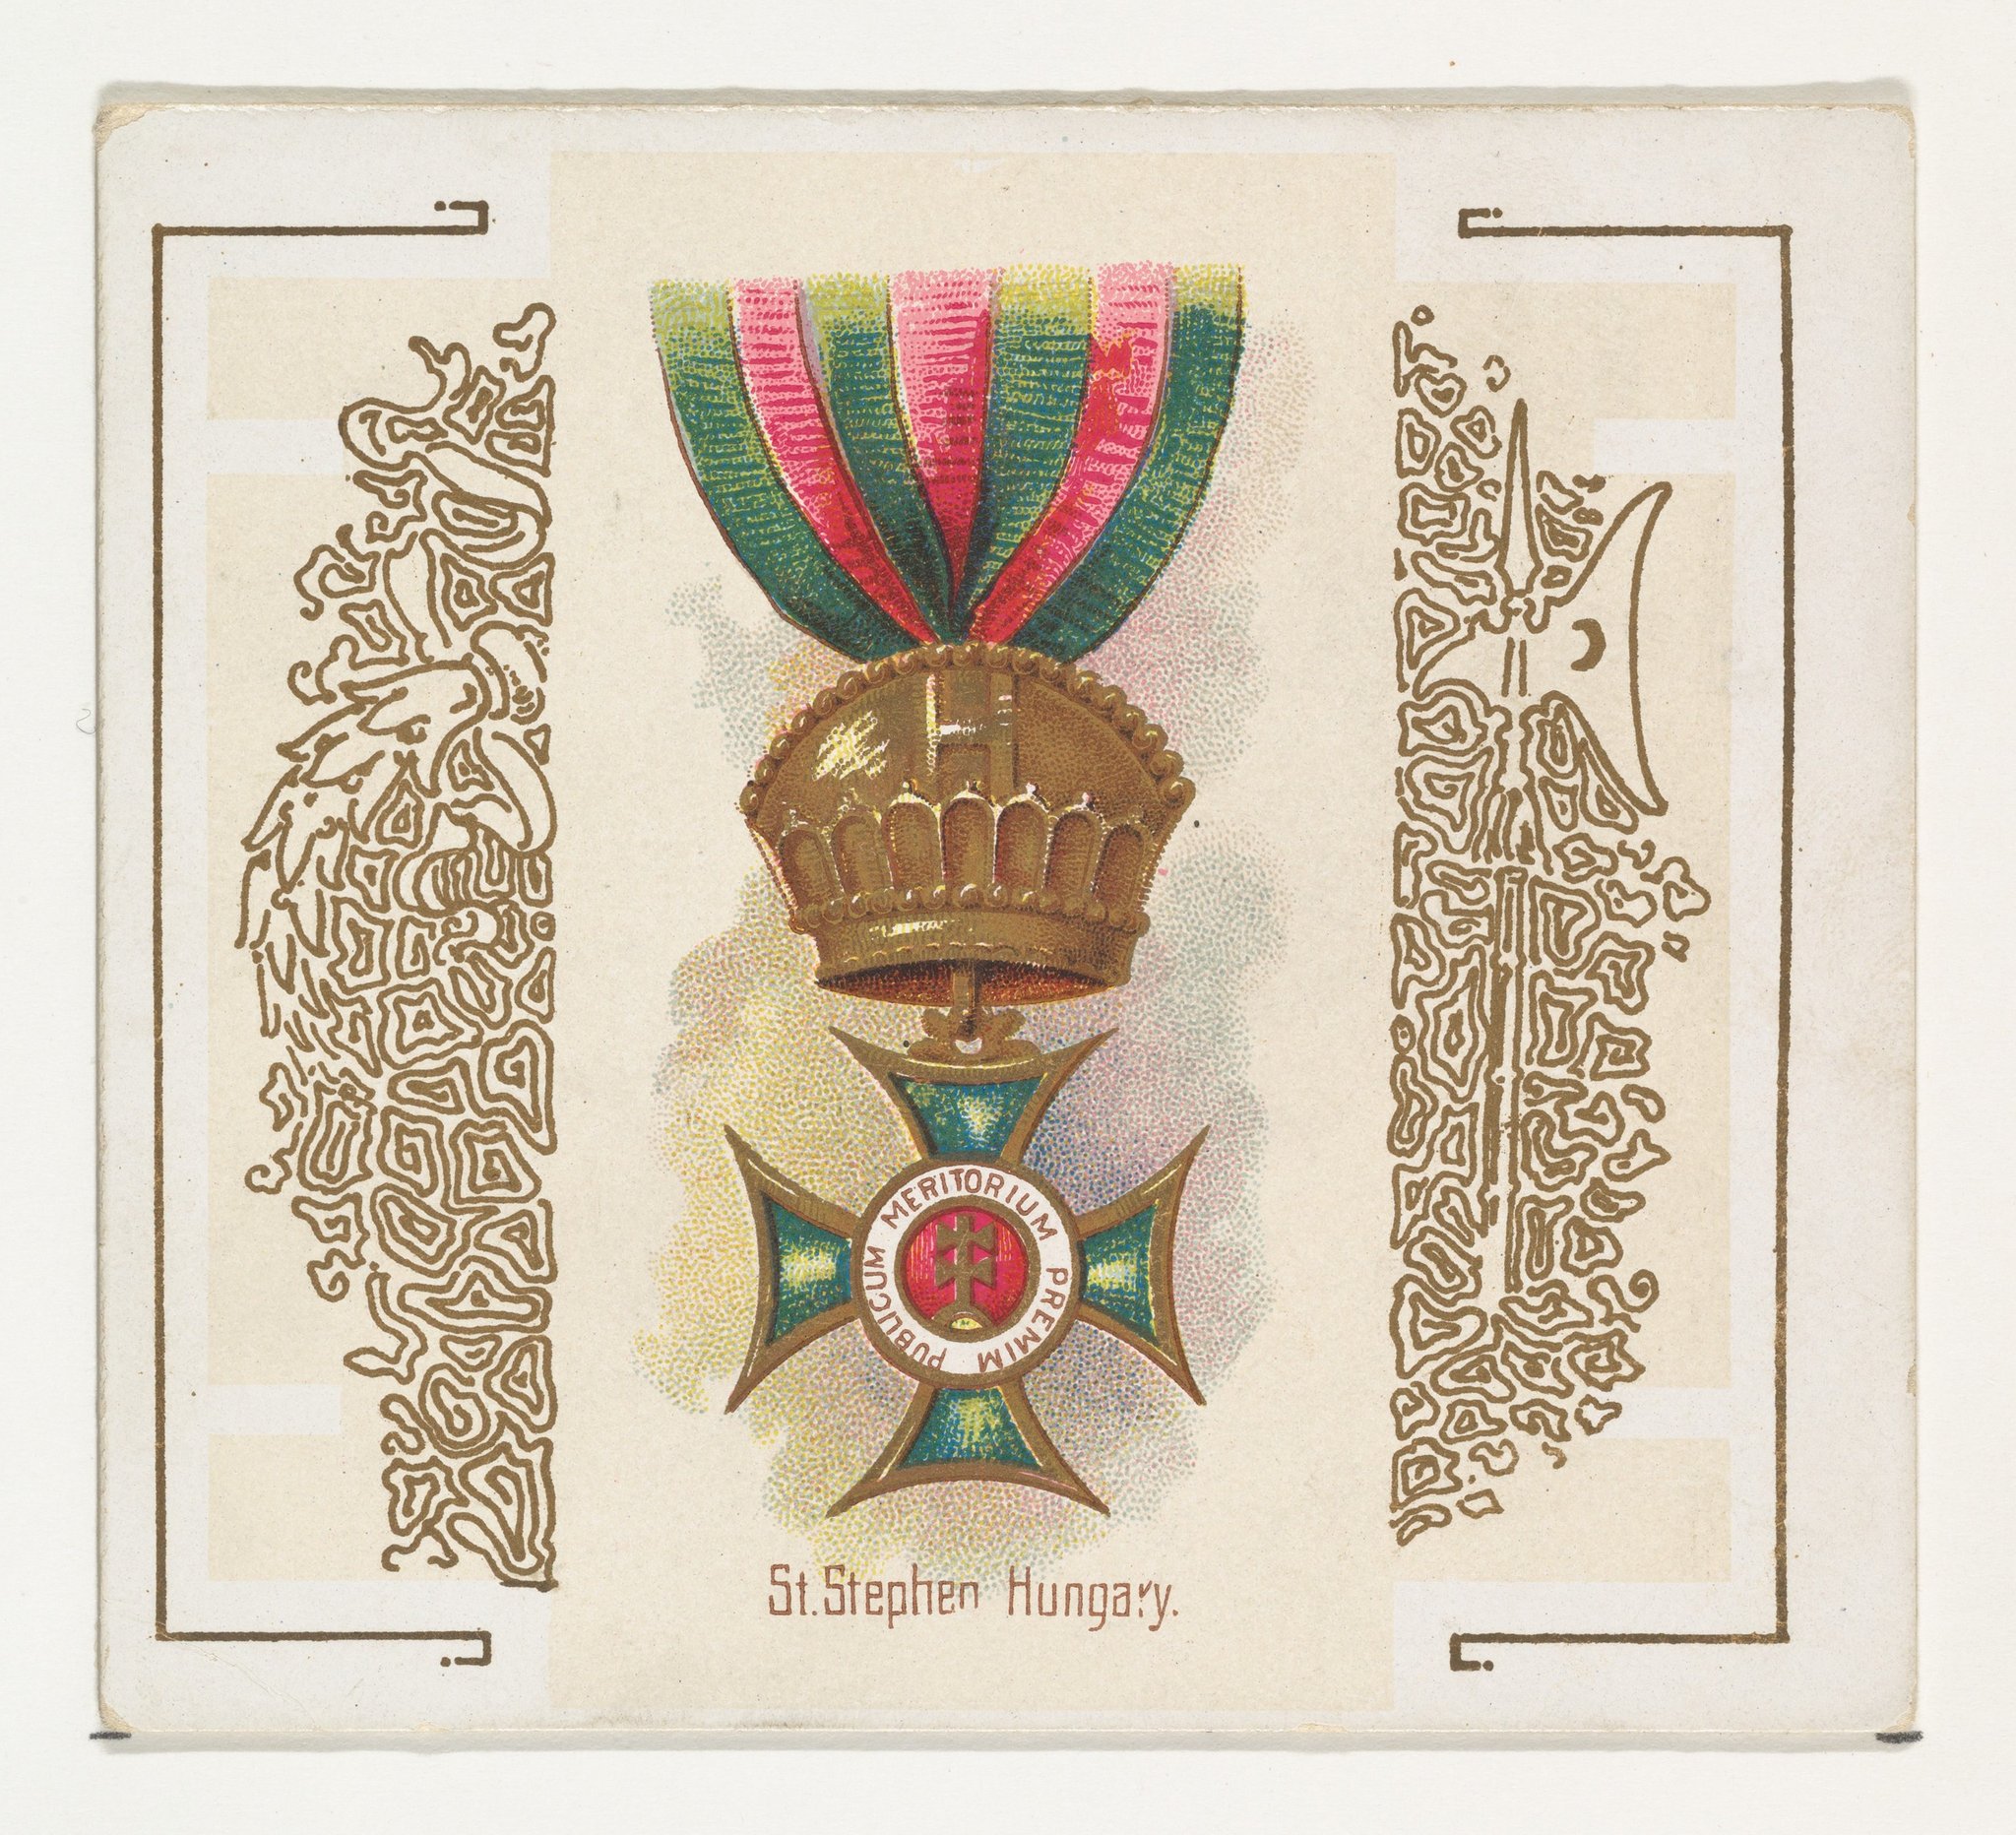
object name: print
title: Saint Stephen, Hungary, from the World's Decorations series (N44) for Allen & Ginter Cigarettes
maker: allen & ginter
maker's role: publisher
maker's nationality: american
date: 1890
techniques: color lithograph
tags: medals